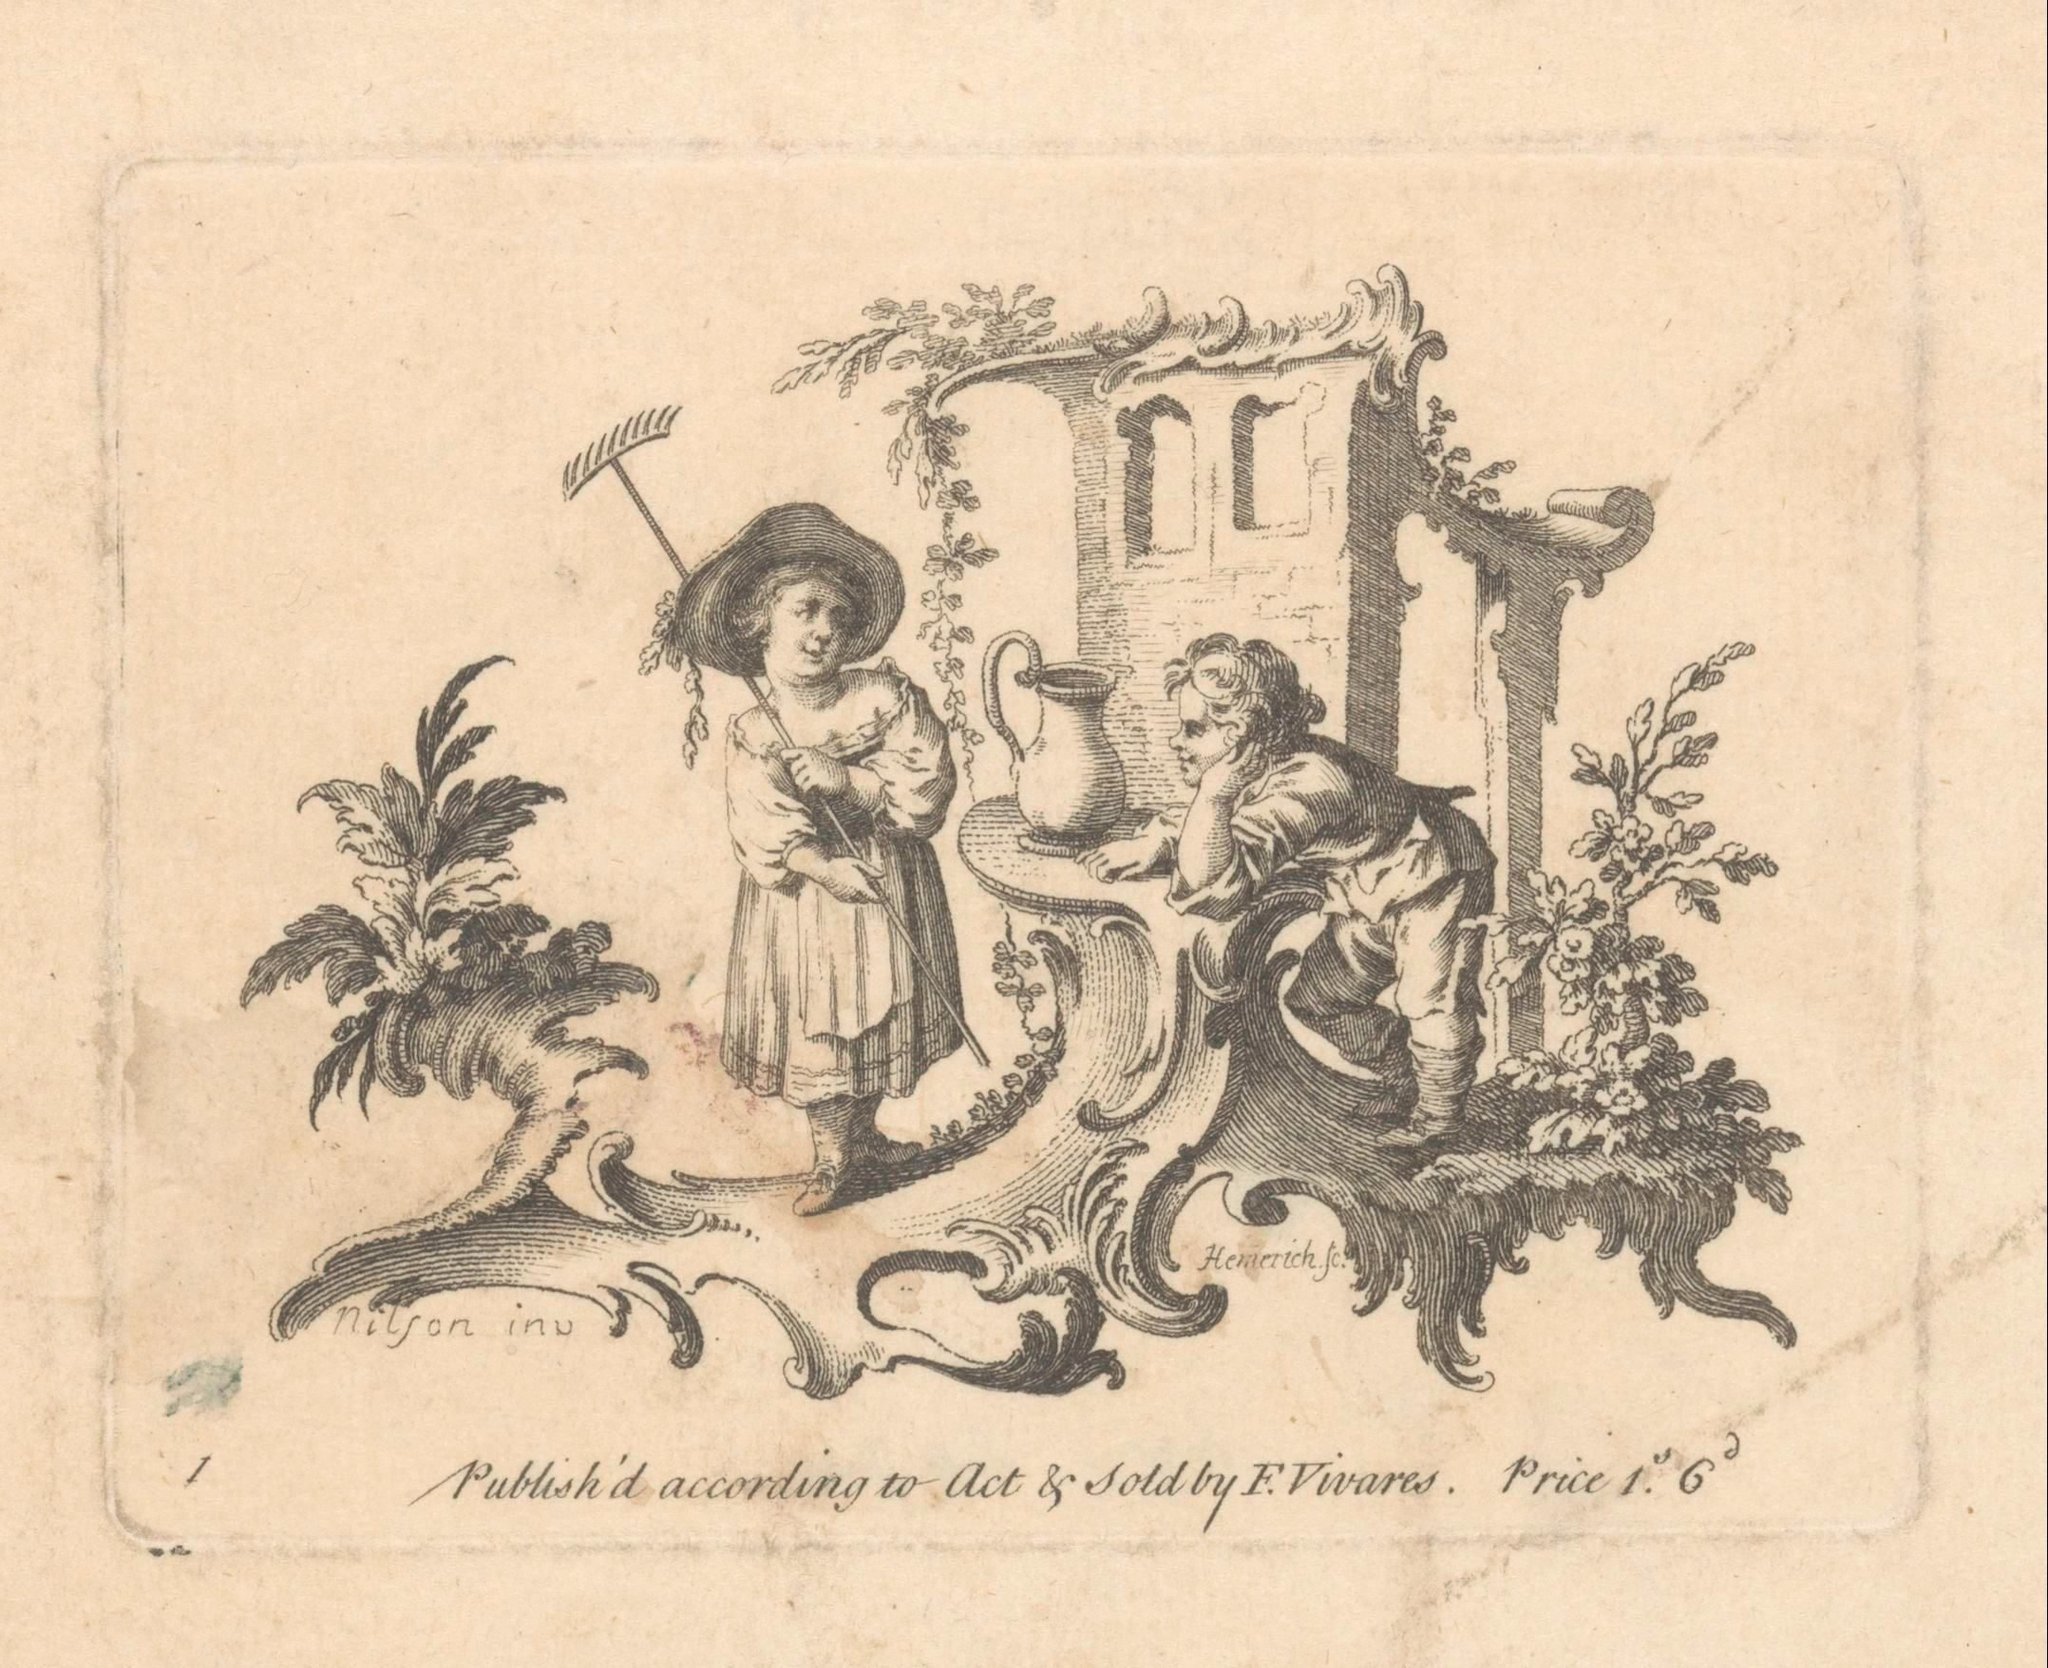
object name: ornament print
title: Man met pijp en vrouw met hark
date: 1731-1780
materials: paper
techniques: engraving, etching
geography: london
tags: pipe ~ tobacco (+ taking (particular) foodstuffs: eating, drinking, smoking, chewing, etc.)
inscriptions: collector's mark: Lugt 2760, collector's mark: Lugt 2228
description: In een landschap met een rocaille ornament staat links een man met een pijp en rechts een vrouw met een hark.